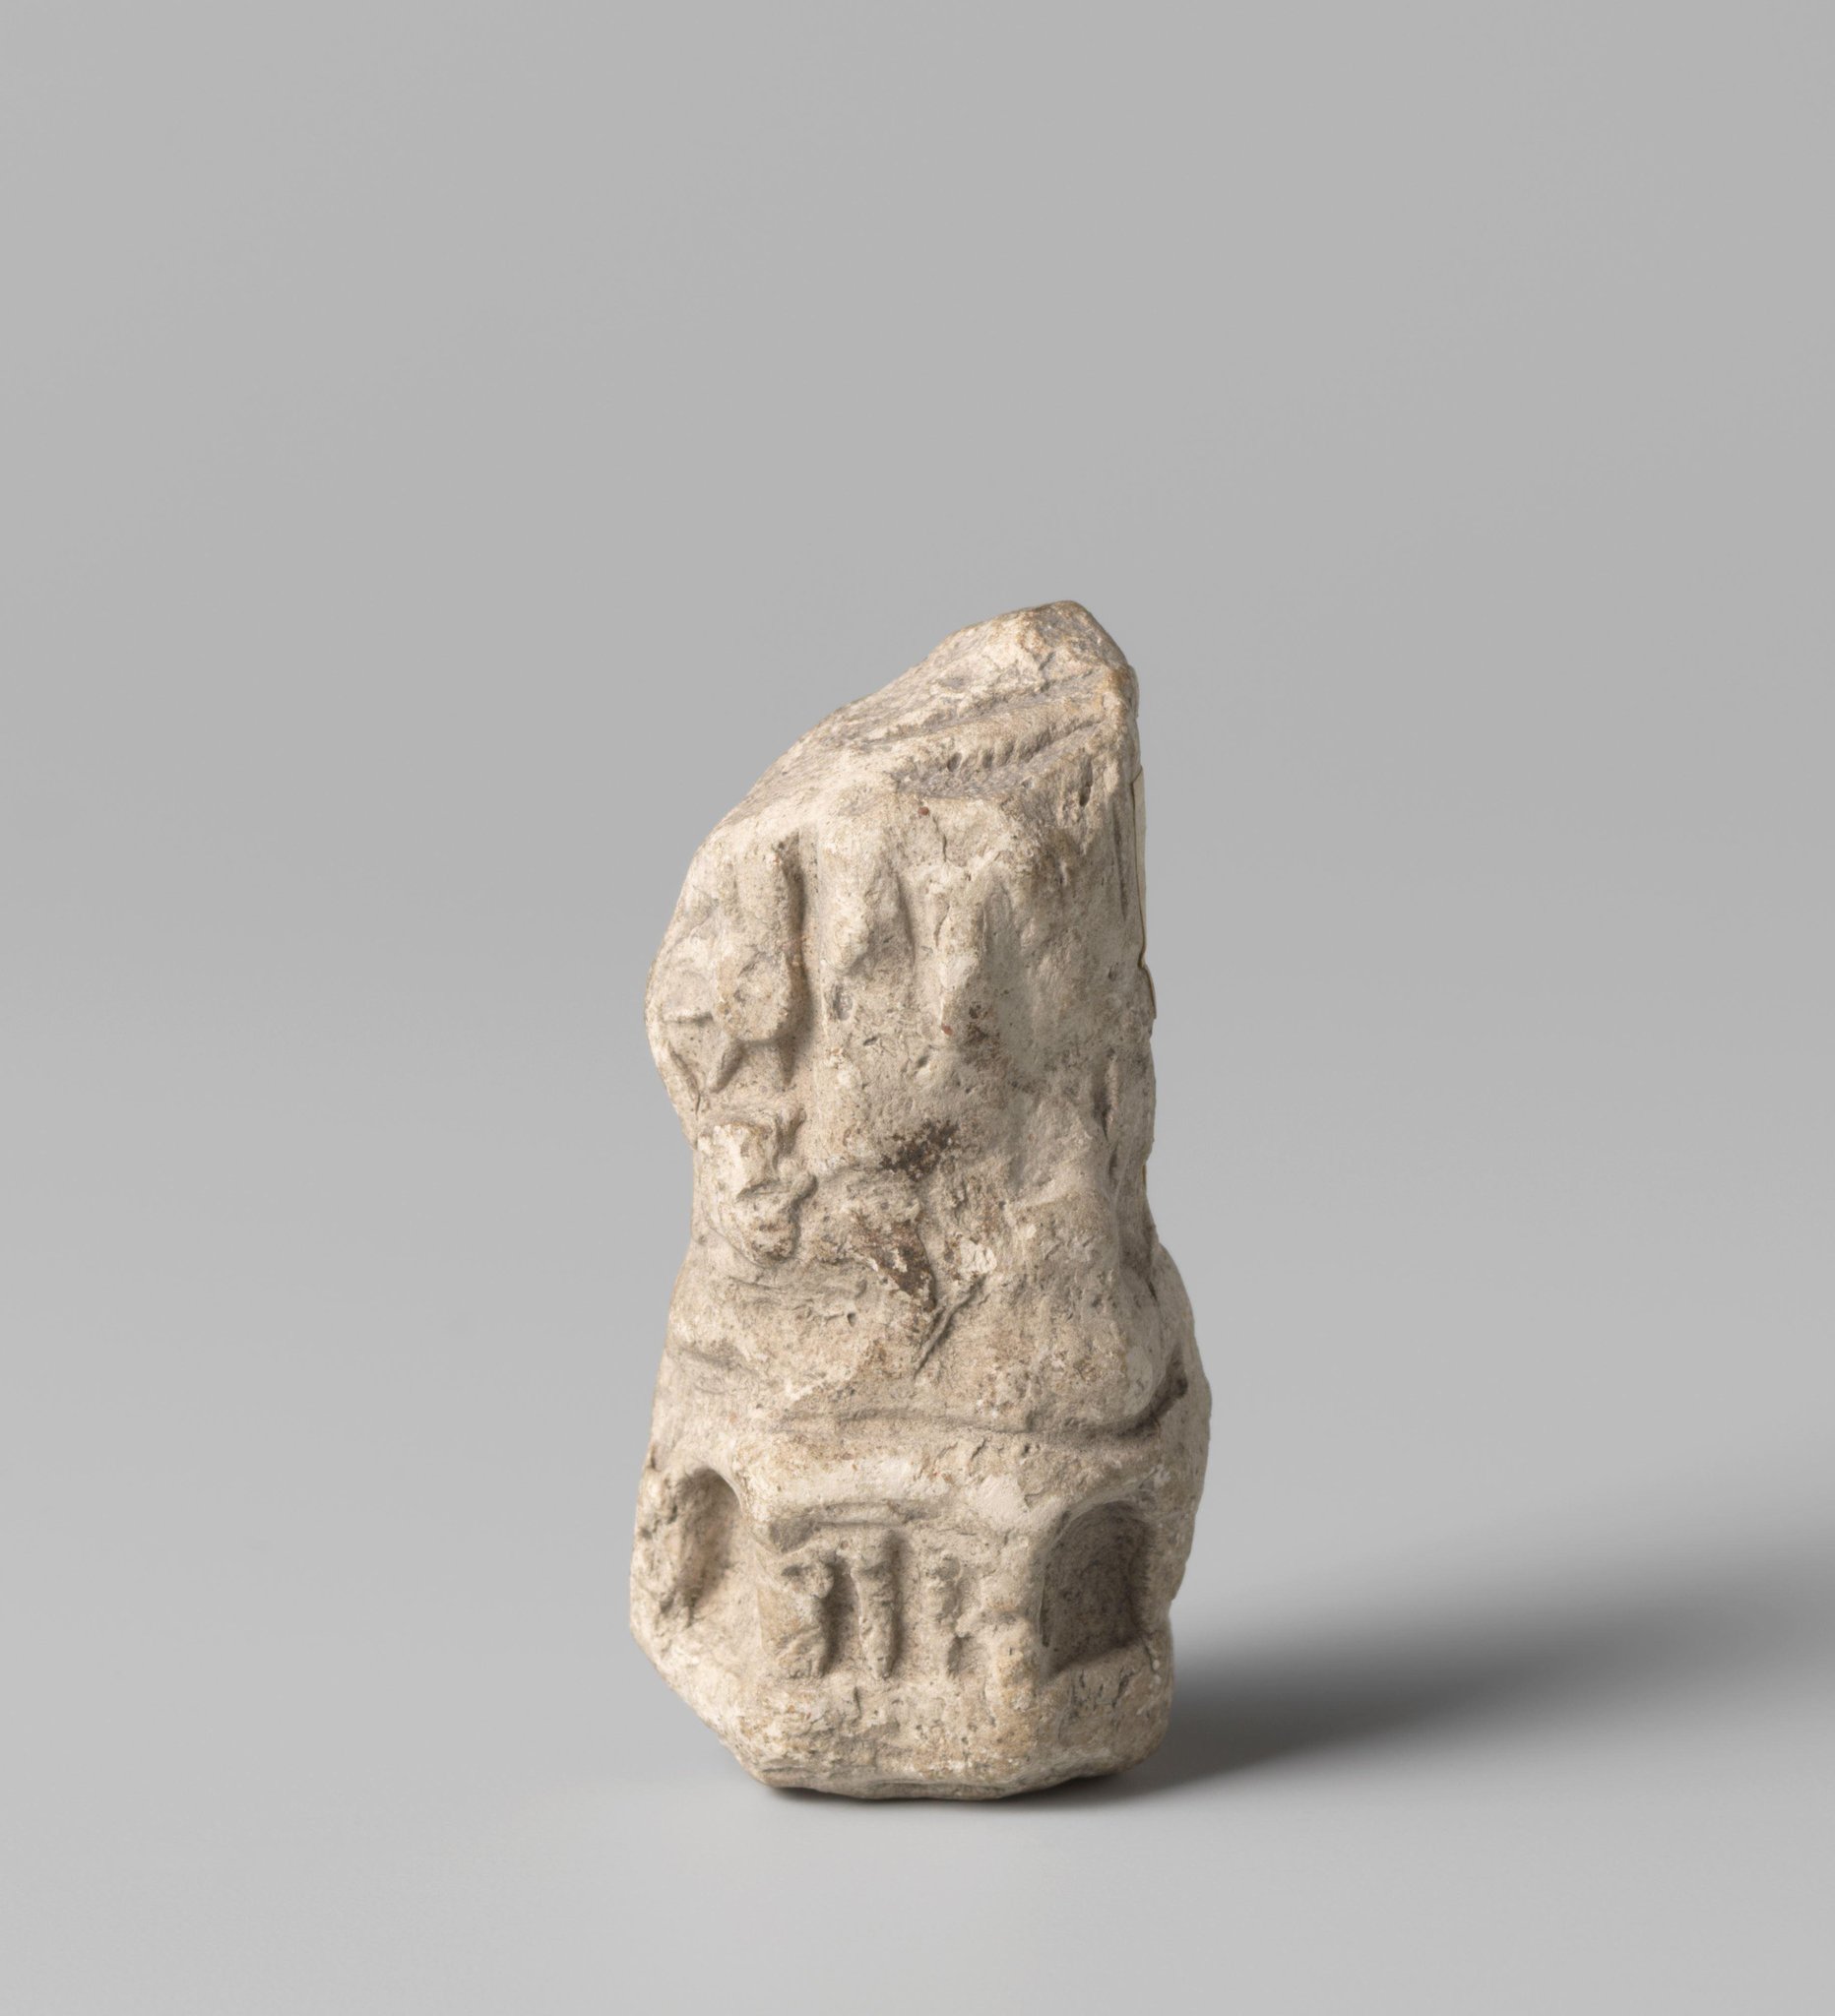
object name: sculpture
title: Fragment van een beeldhouwwerk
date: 1400-1950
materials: clay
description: Beneden gedeelte van een heilige beeld staande op een leeuw, daarnaast een rad.